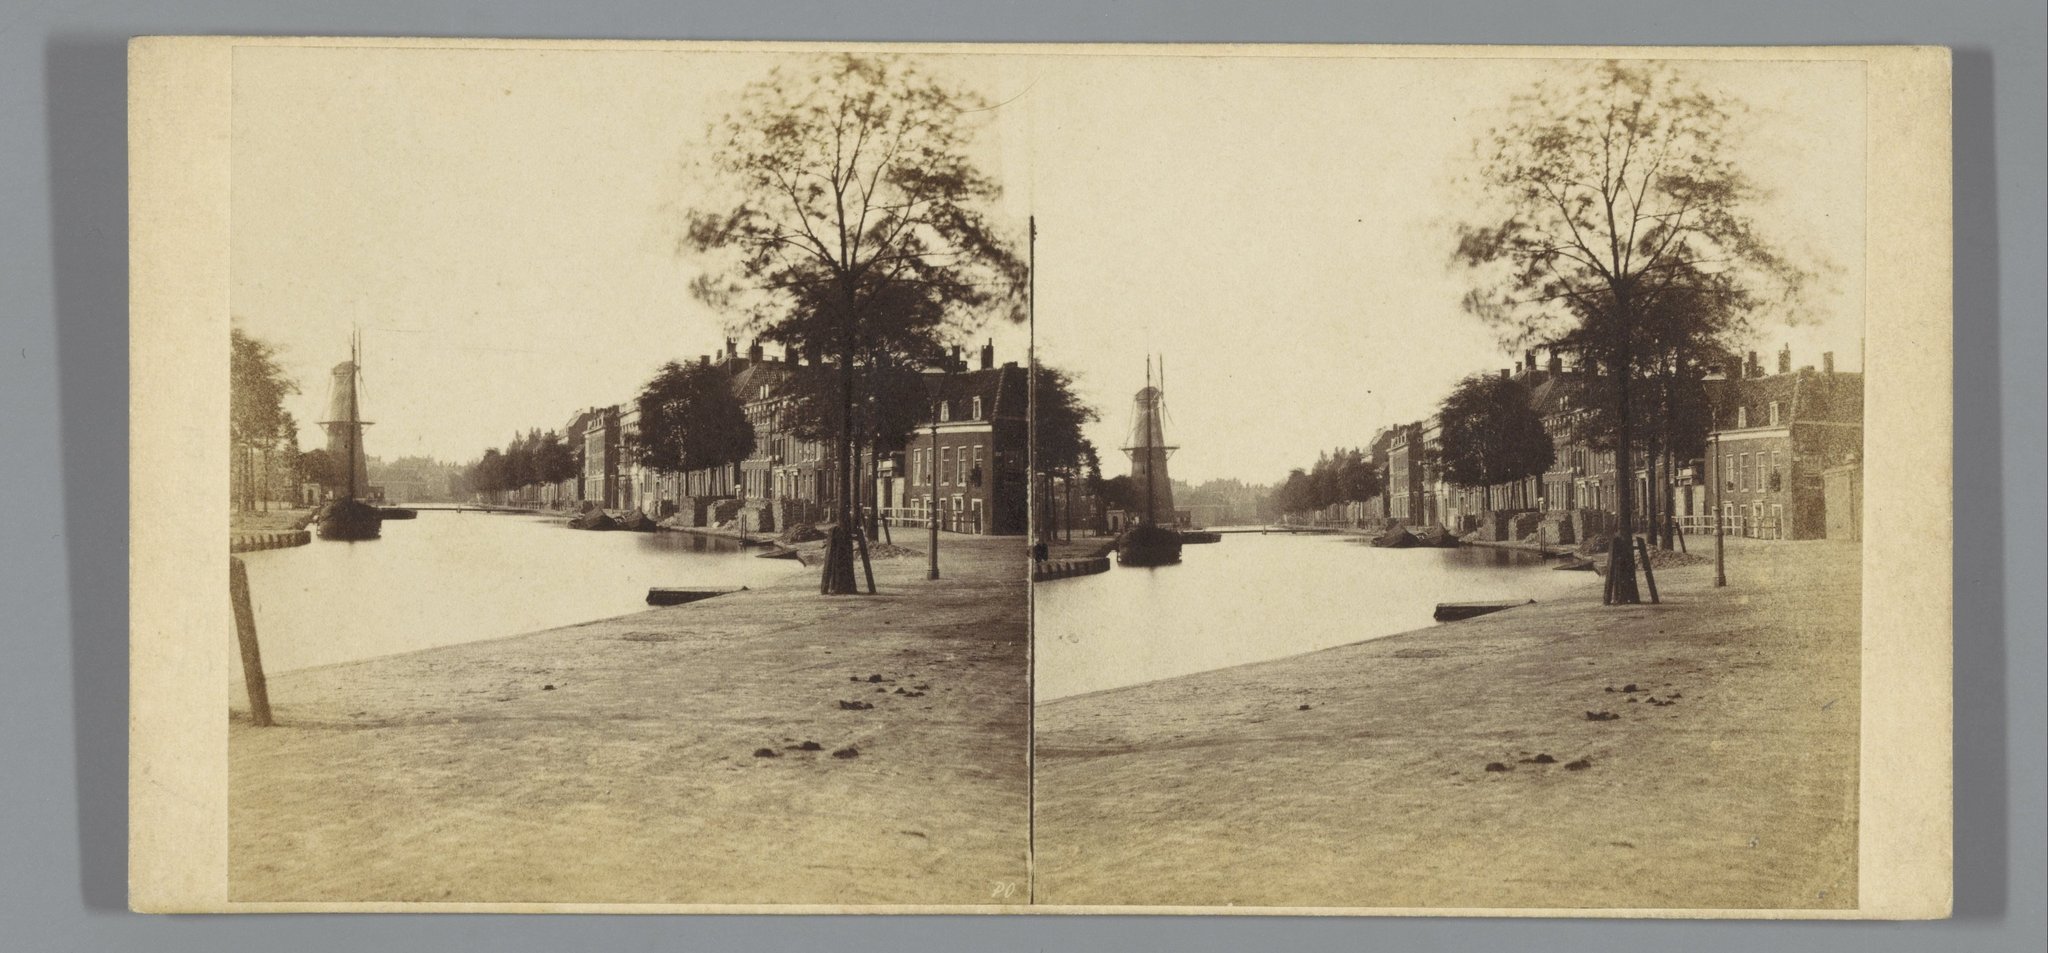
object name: stereograph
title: Coolsingel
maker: pieter oosterhuis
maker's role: draughtsman, print maker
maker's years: 1816-1885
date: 1859-1865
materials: cardboard, paper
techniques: albumen print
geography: rotterdam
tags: canals, waters (in city)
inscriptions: initials: ‘P.O.’, number: ‘35.’, number: ‘No. 218’